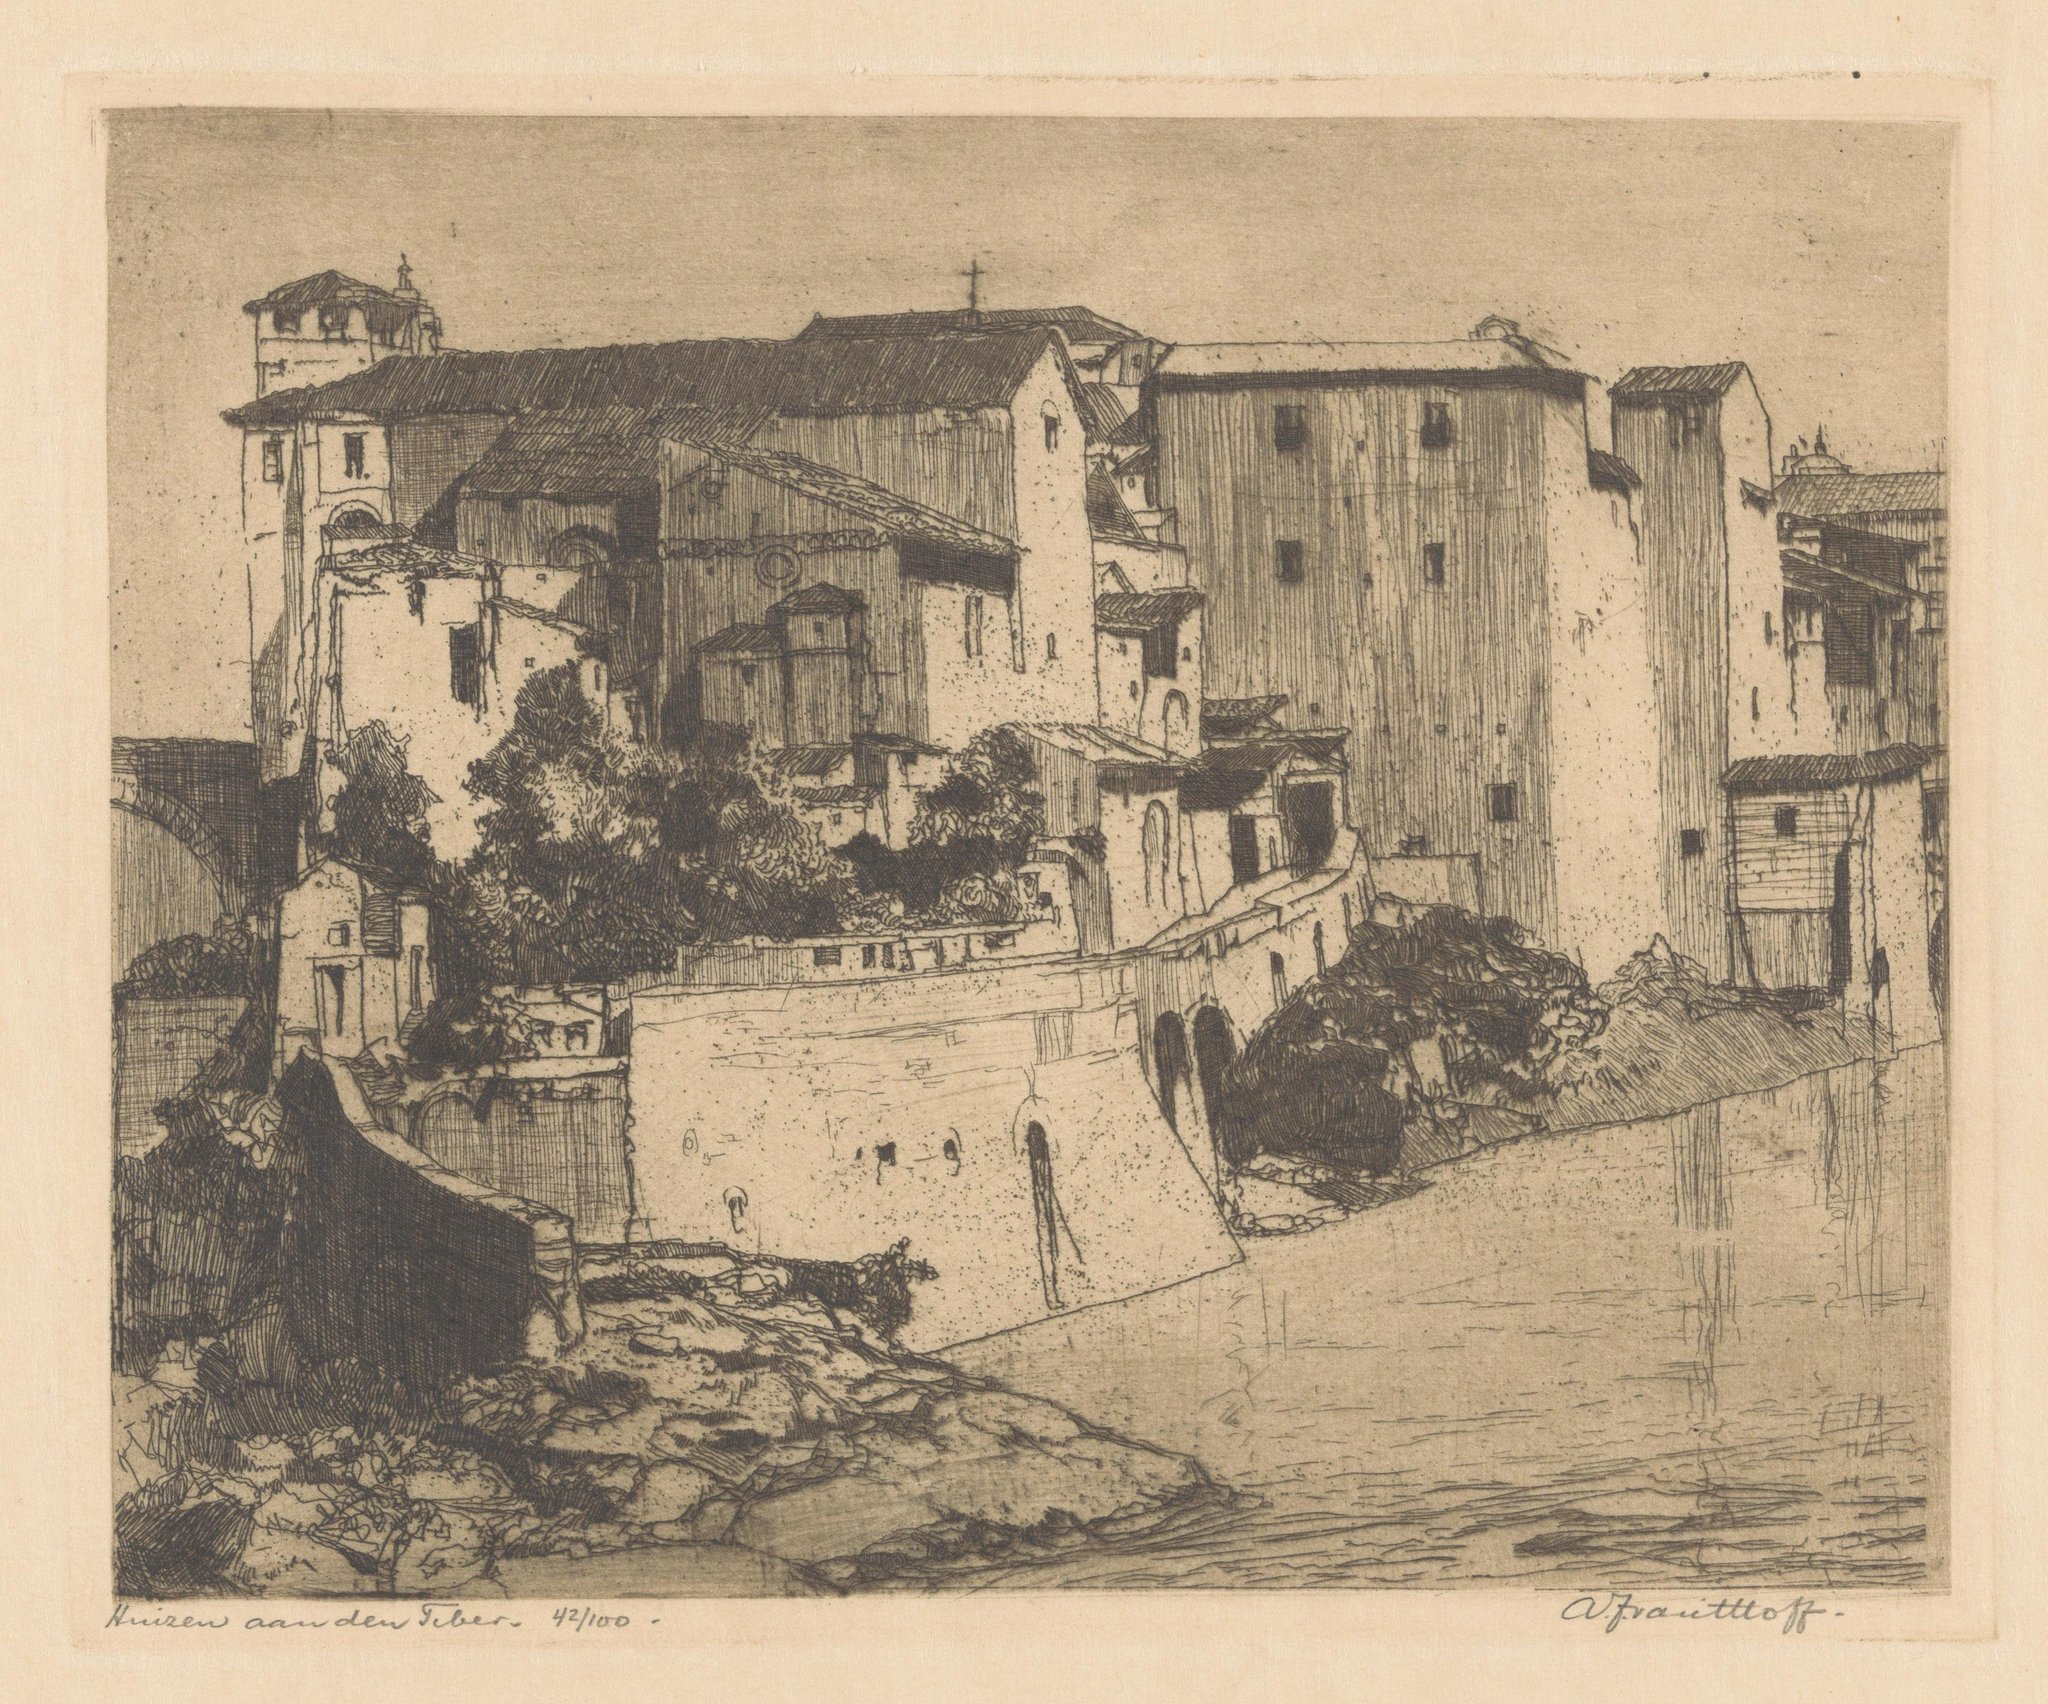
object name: print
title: Huizen aan den Tiber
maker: adriaan j. van t hoff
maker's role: draughtsman, print maker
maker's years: 1893-1939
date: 1908-1932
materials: paper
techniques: etching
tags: city-view in general; 'veduta', river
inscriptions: collector's mark: Lugt 2228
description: Rechts de rivier met op de oever huizen. Helemaal links een weg en een poort.